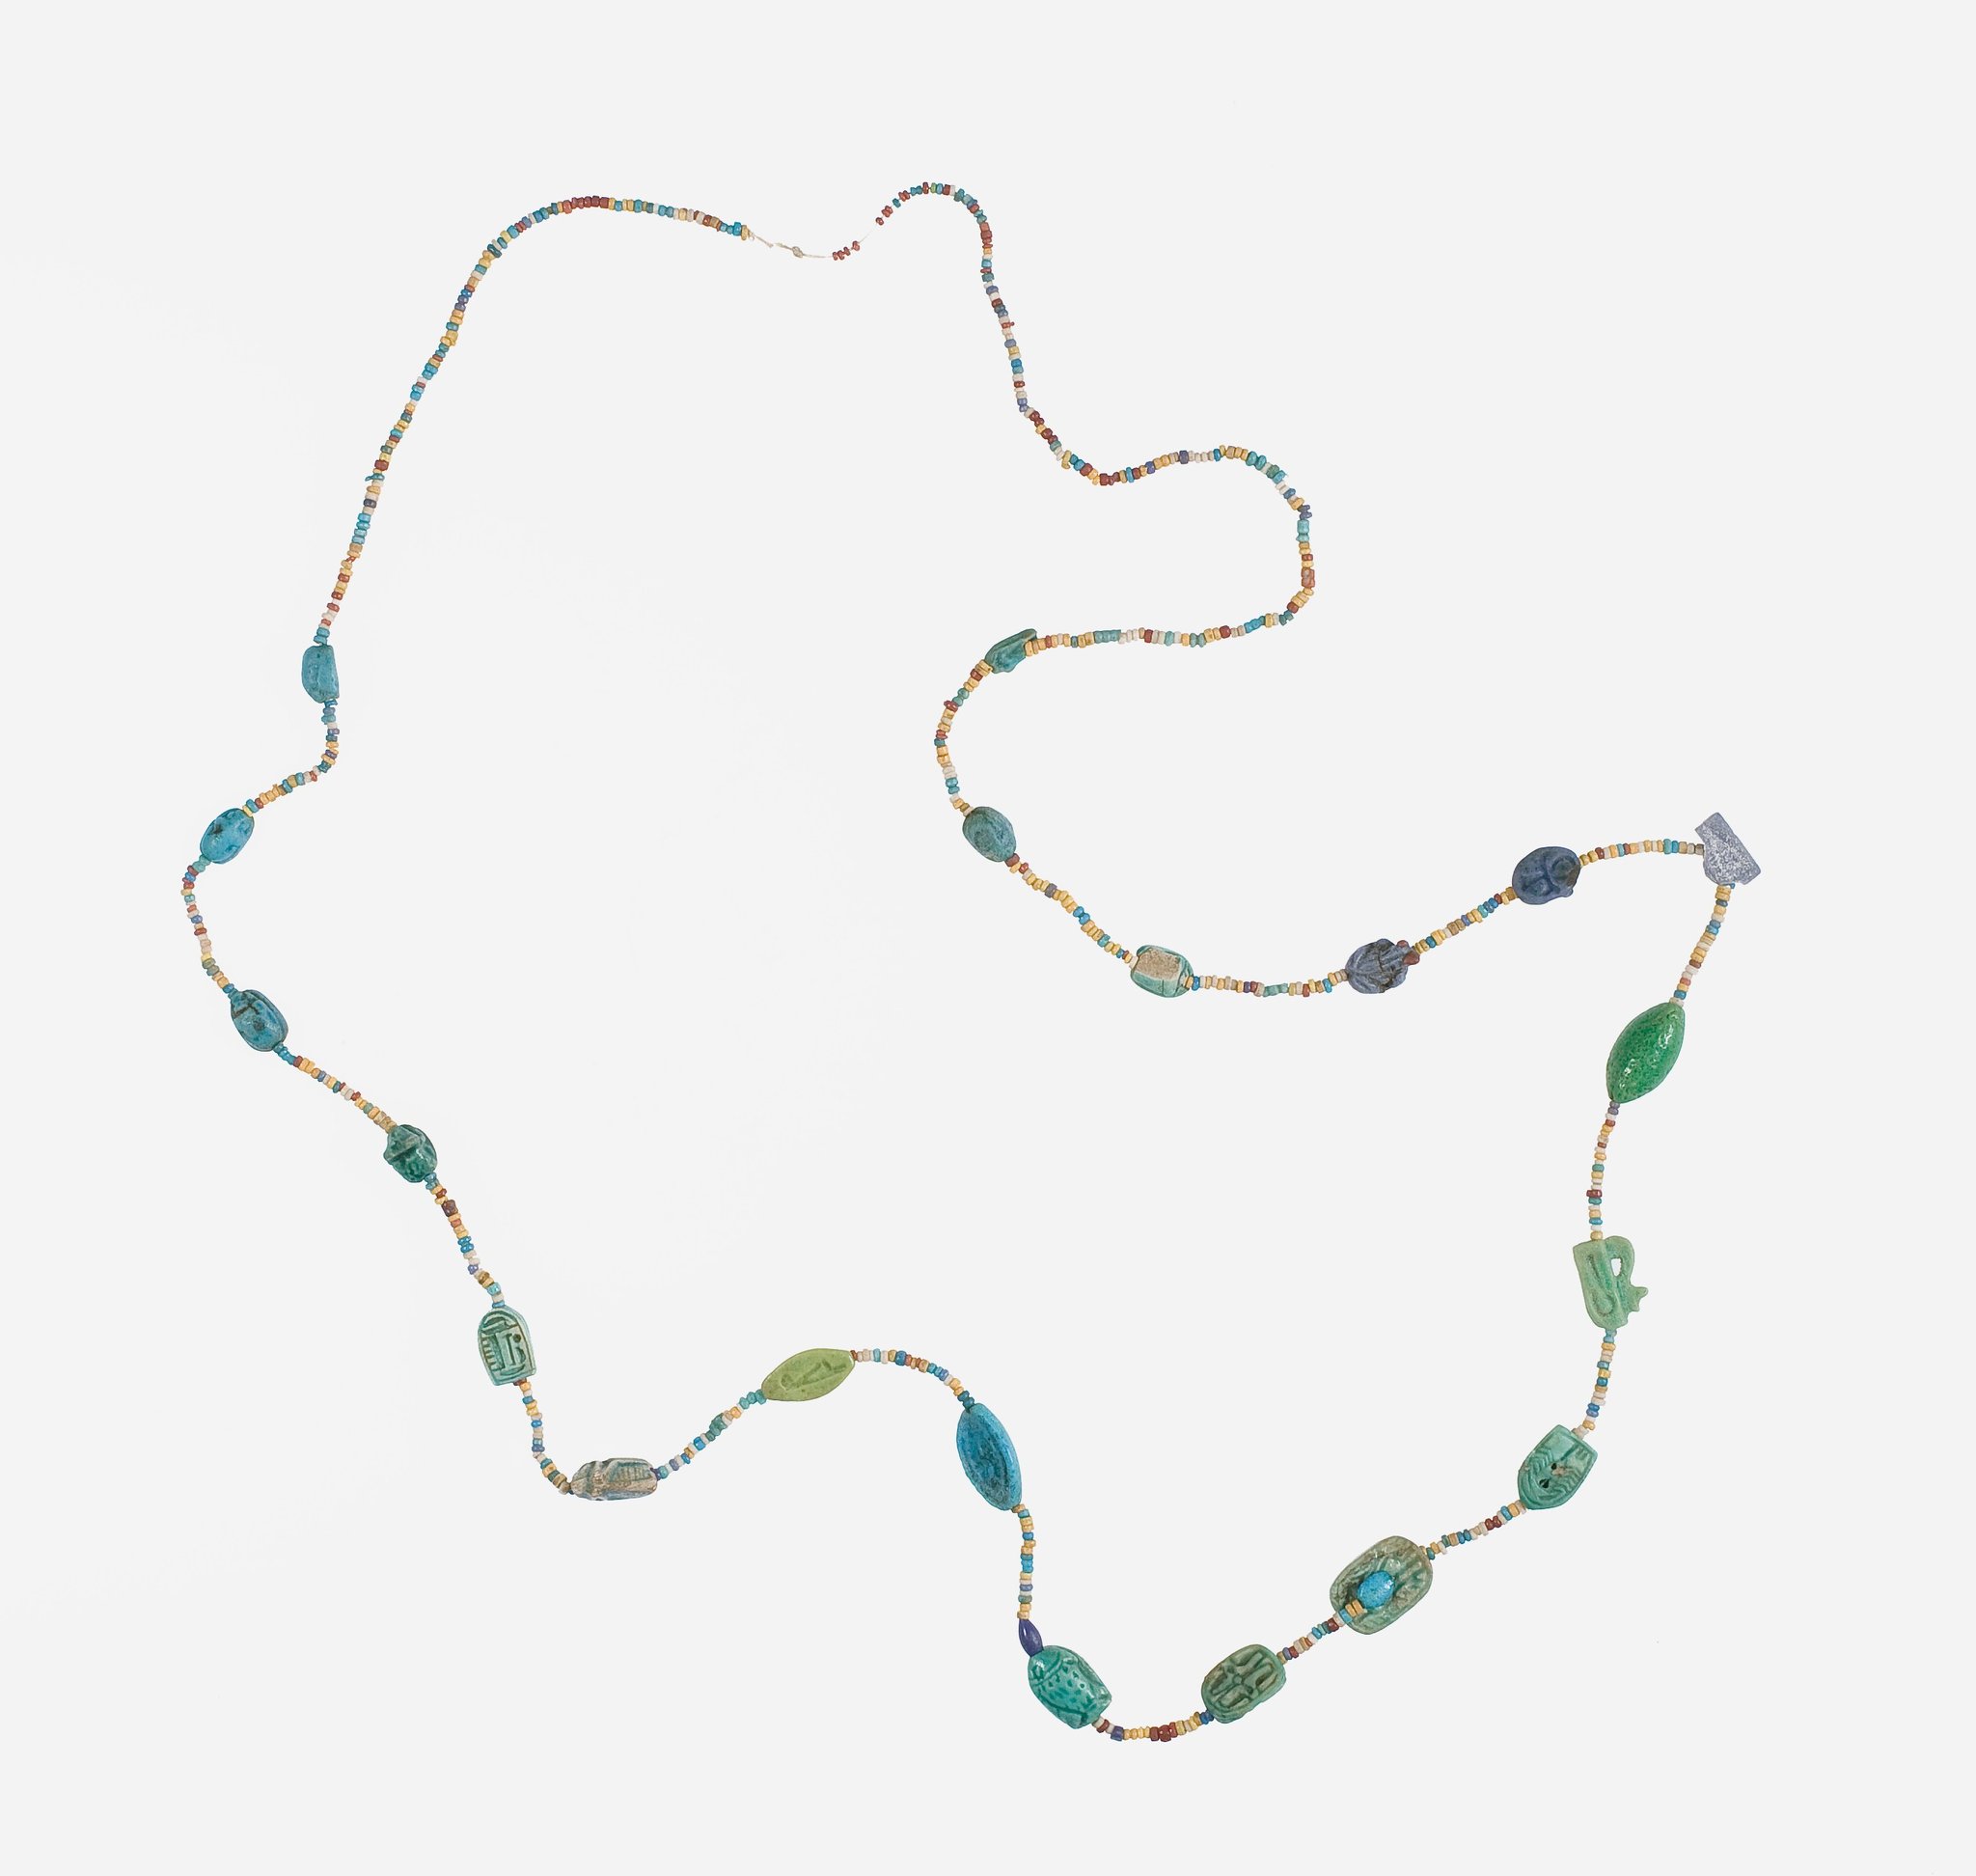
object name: necklace, scarab, menkheperre, nebmaatre, grasshopper, frog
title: Amulets and string of beads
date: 1390-1352 BCE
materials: faience, stone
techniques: glazing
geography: egypt